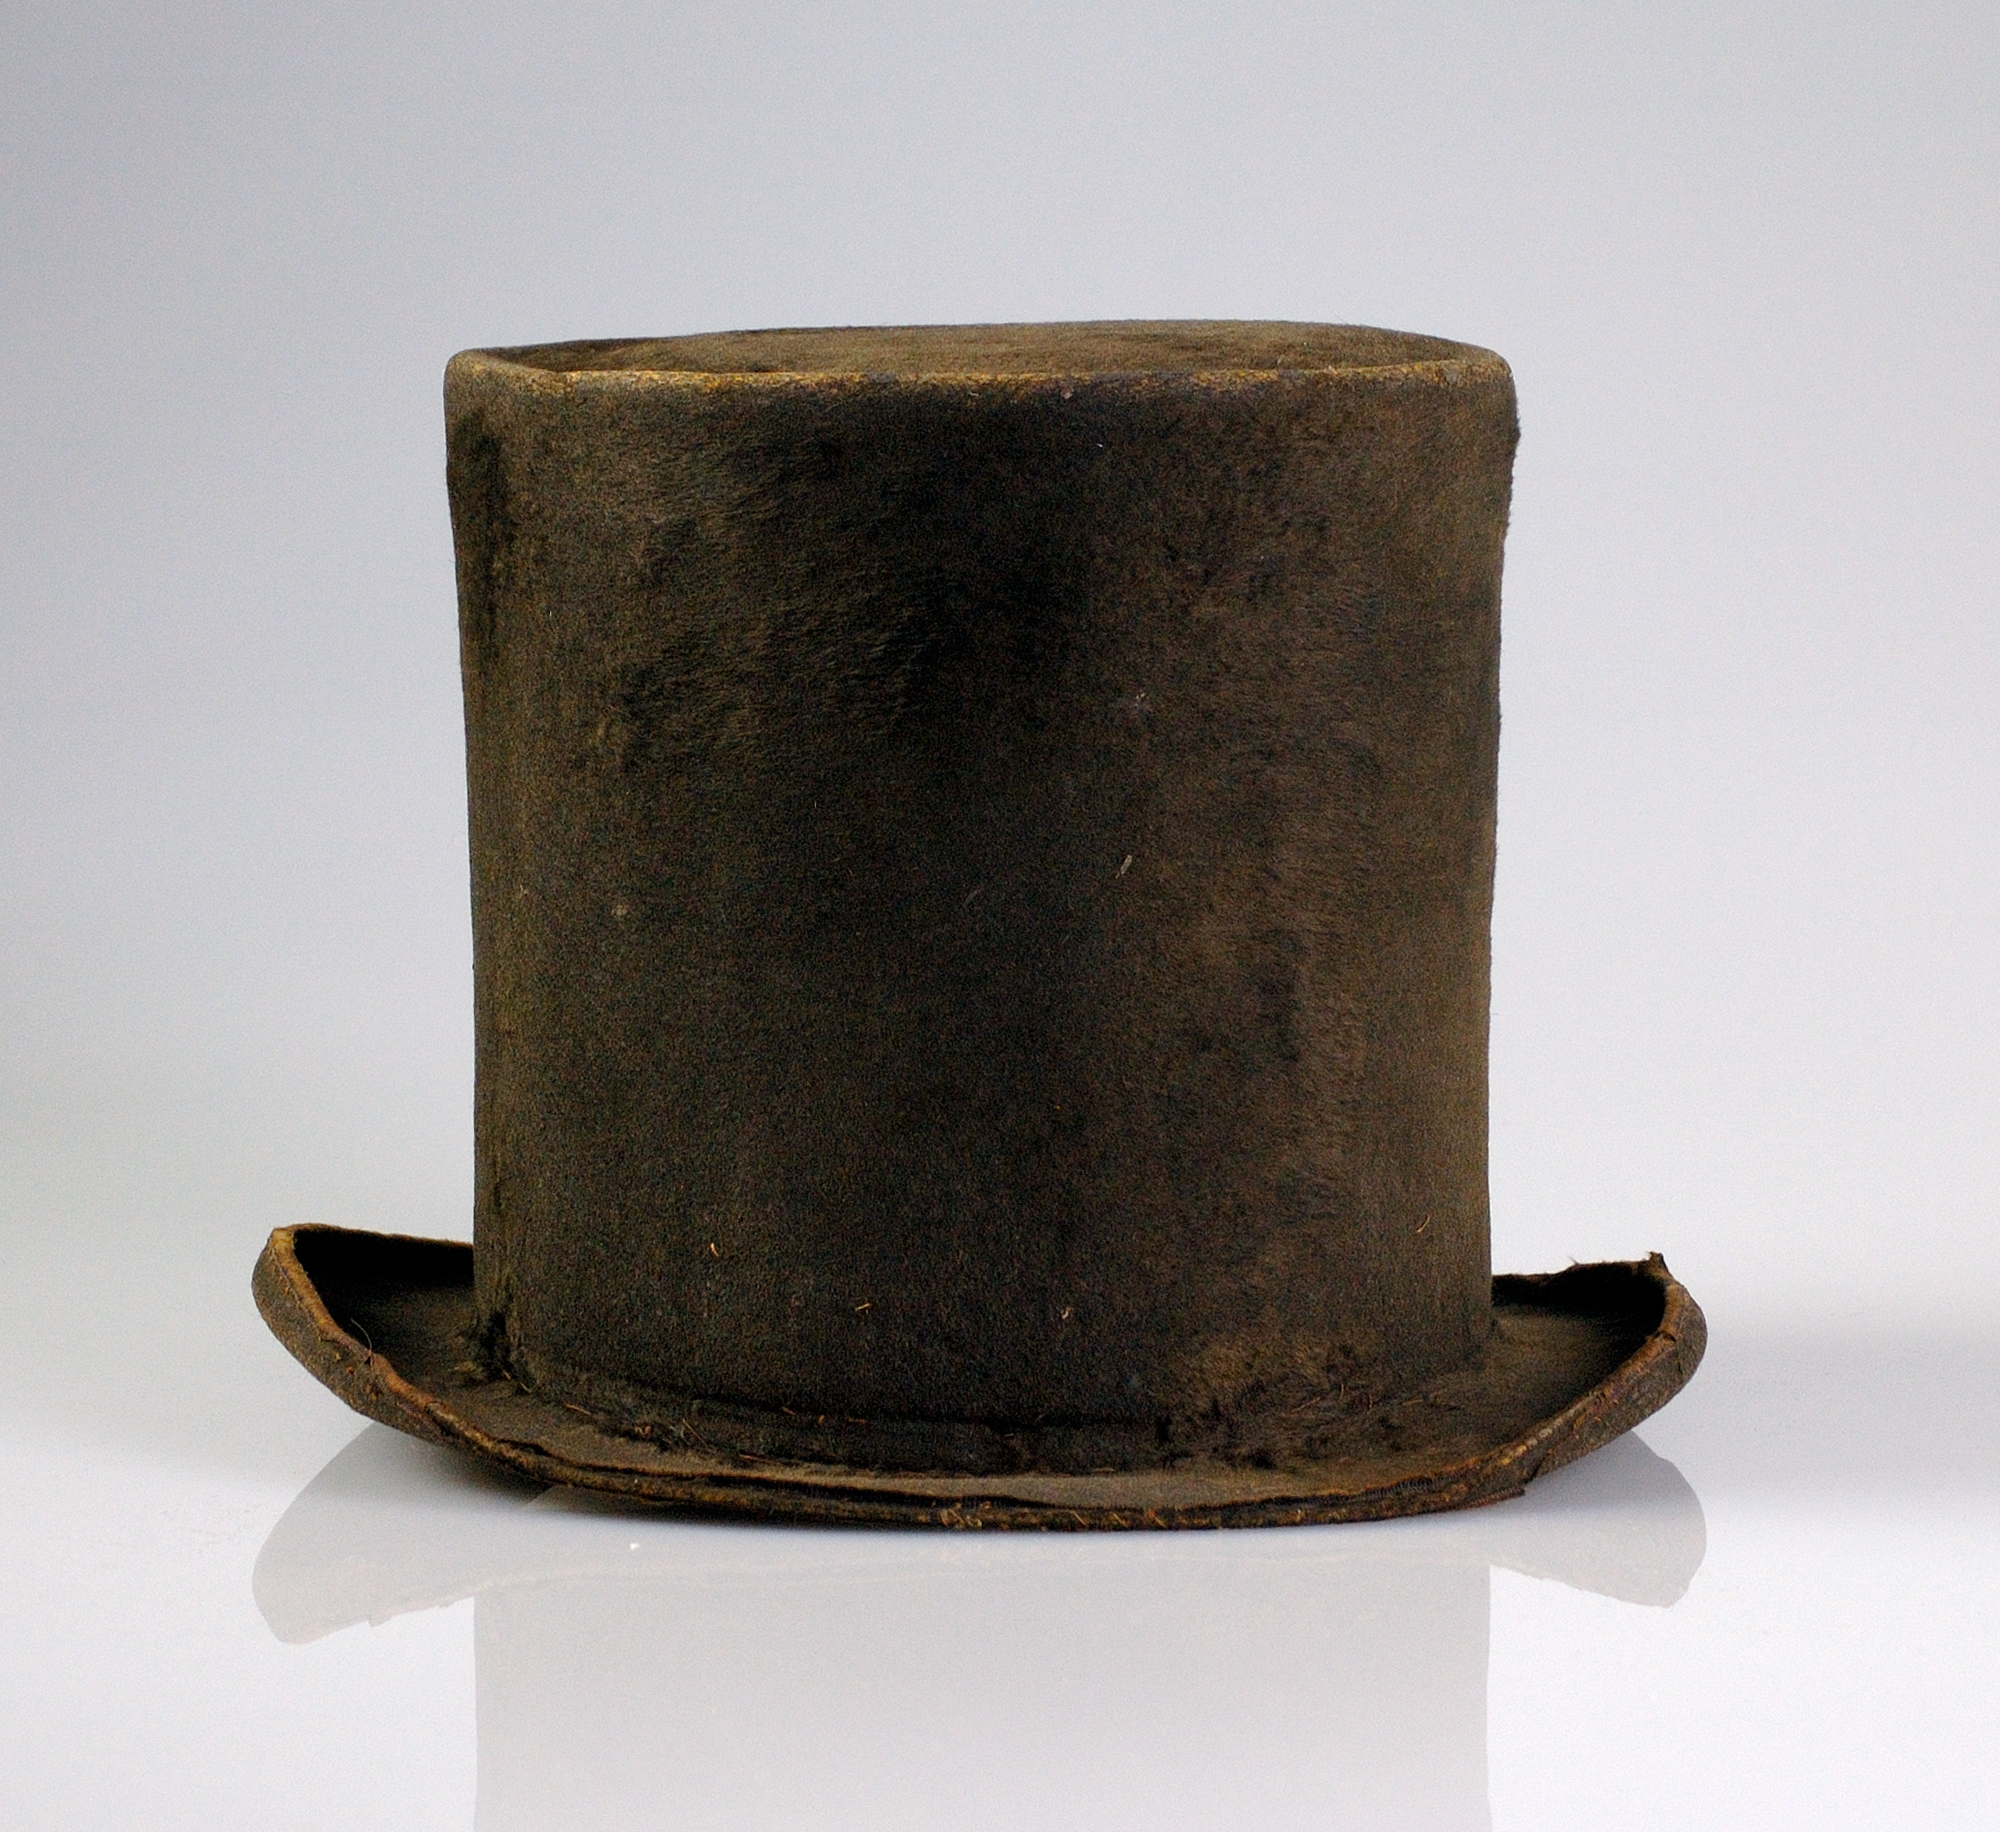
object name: top hat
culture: american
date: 1835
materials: fur, silk